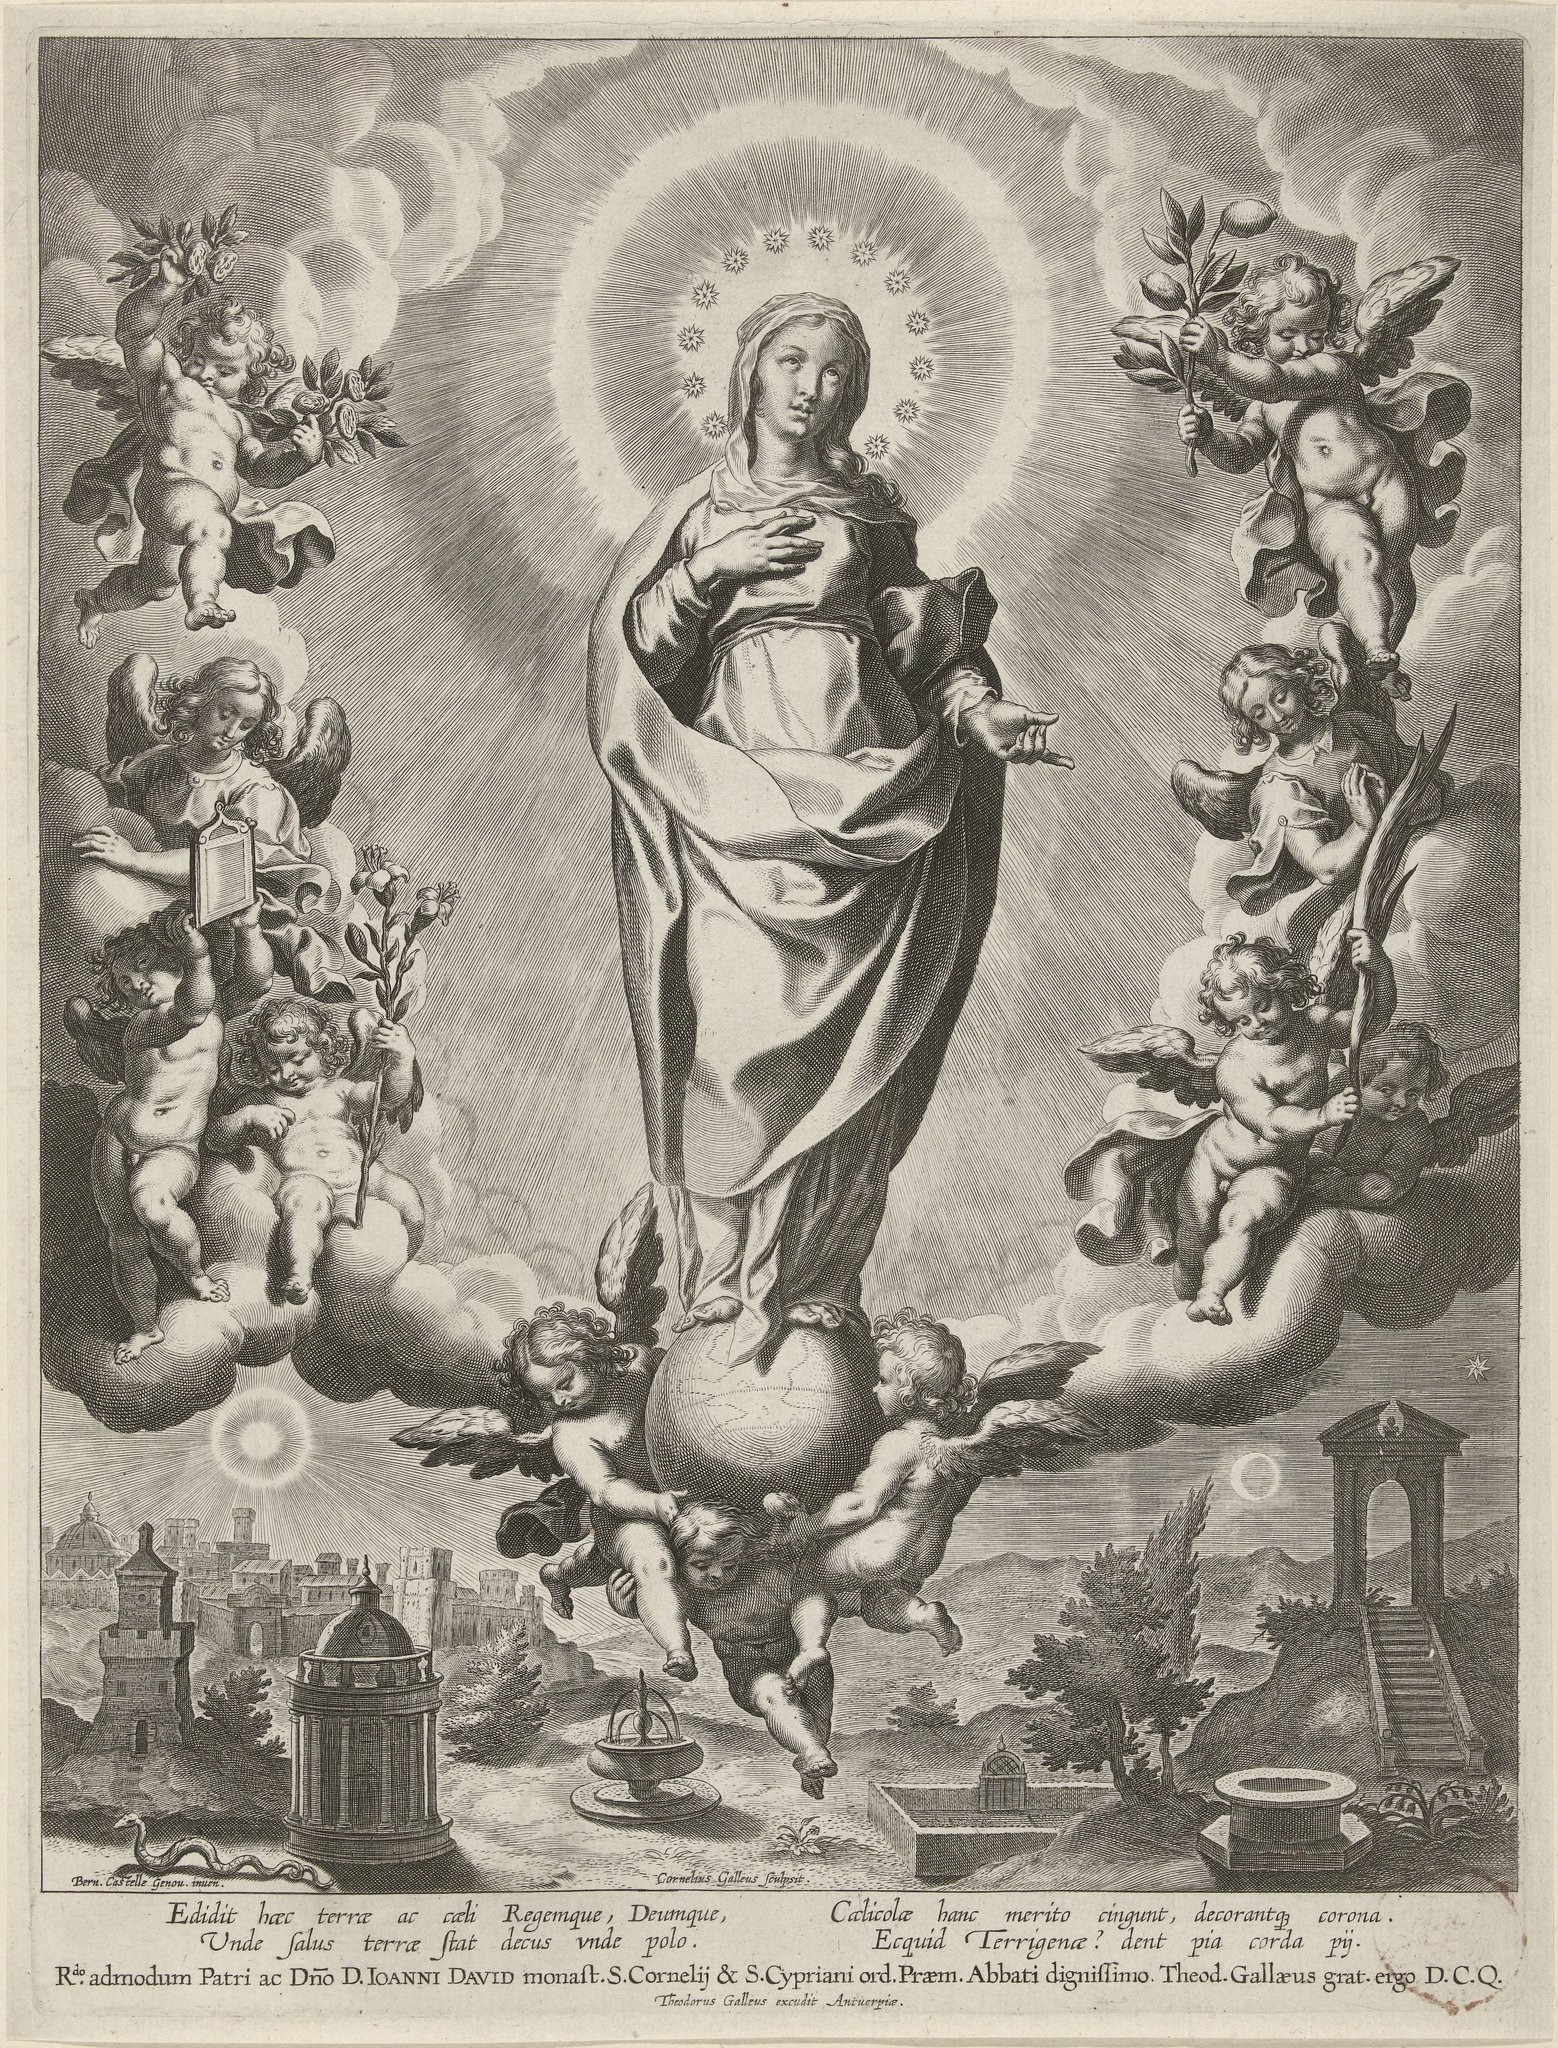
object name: print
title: Maria op een globe, omringd door engelen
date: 1586-1633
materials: paper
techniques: engraving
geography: southern netherlands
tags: garden of virtues (+ mary), fountain of life (+ mary), mary standing or resting on the earth (+ angels floating in the air)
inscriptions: collector's mark: Lugt 240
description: Maria staat op een globe die gedragen wordt door engelen. Aan weerszijden engelen die haar attributen dragen: een lelietak en een palmtak, takken met fruit en een boek. In het landschap staan symbolische gebouwen die met Maria in verband gebracht kunnen worden: een fontein, een gesloten tuin, een bron, een trap die naar een poort leidt, een ronde tempel. Op de achtergrond een stad. Aan de hemel de zon en de maan.